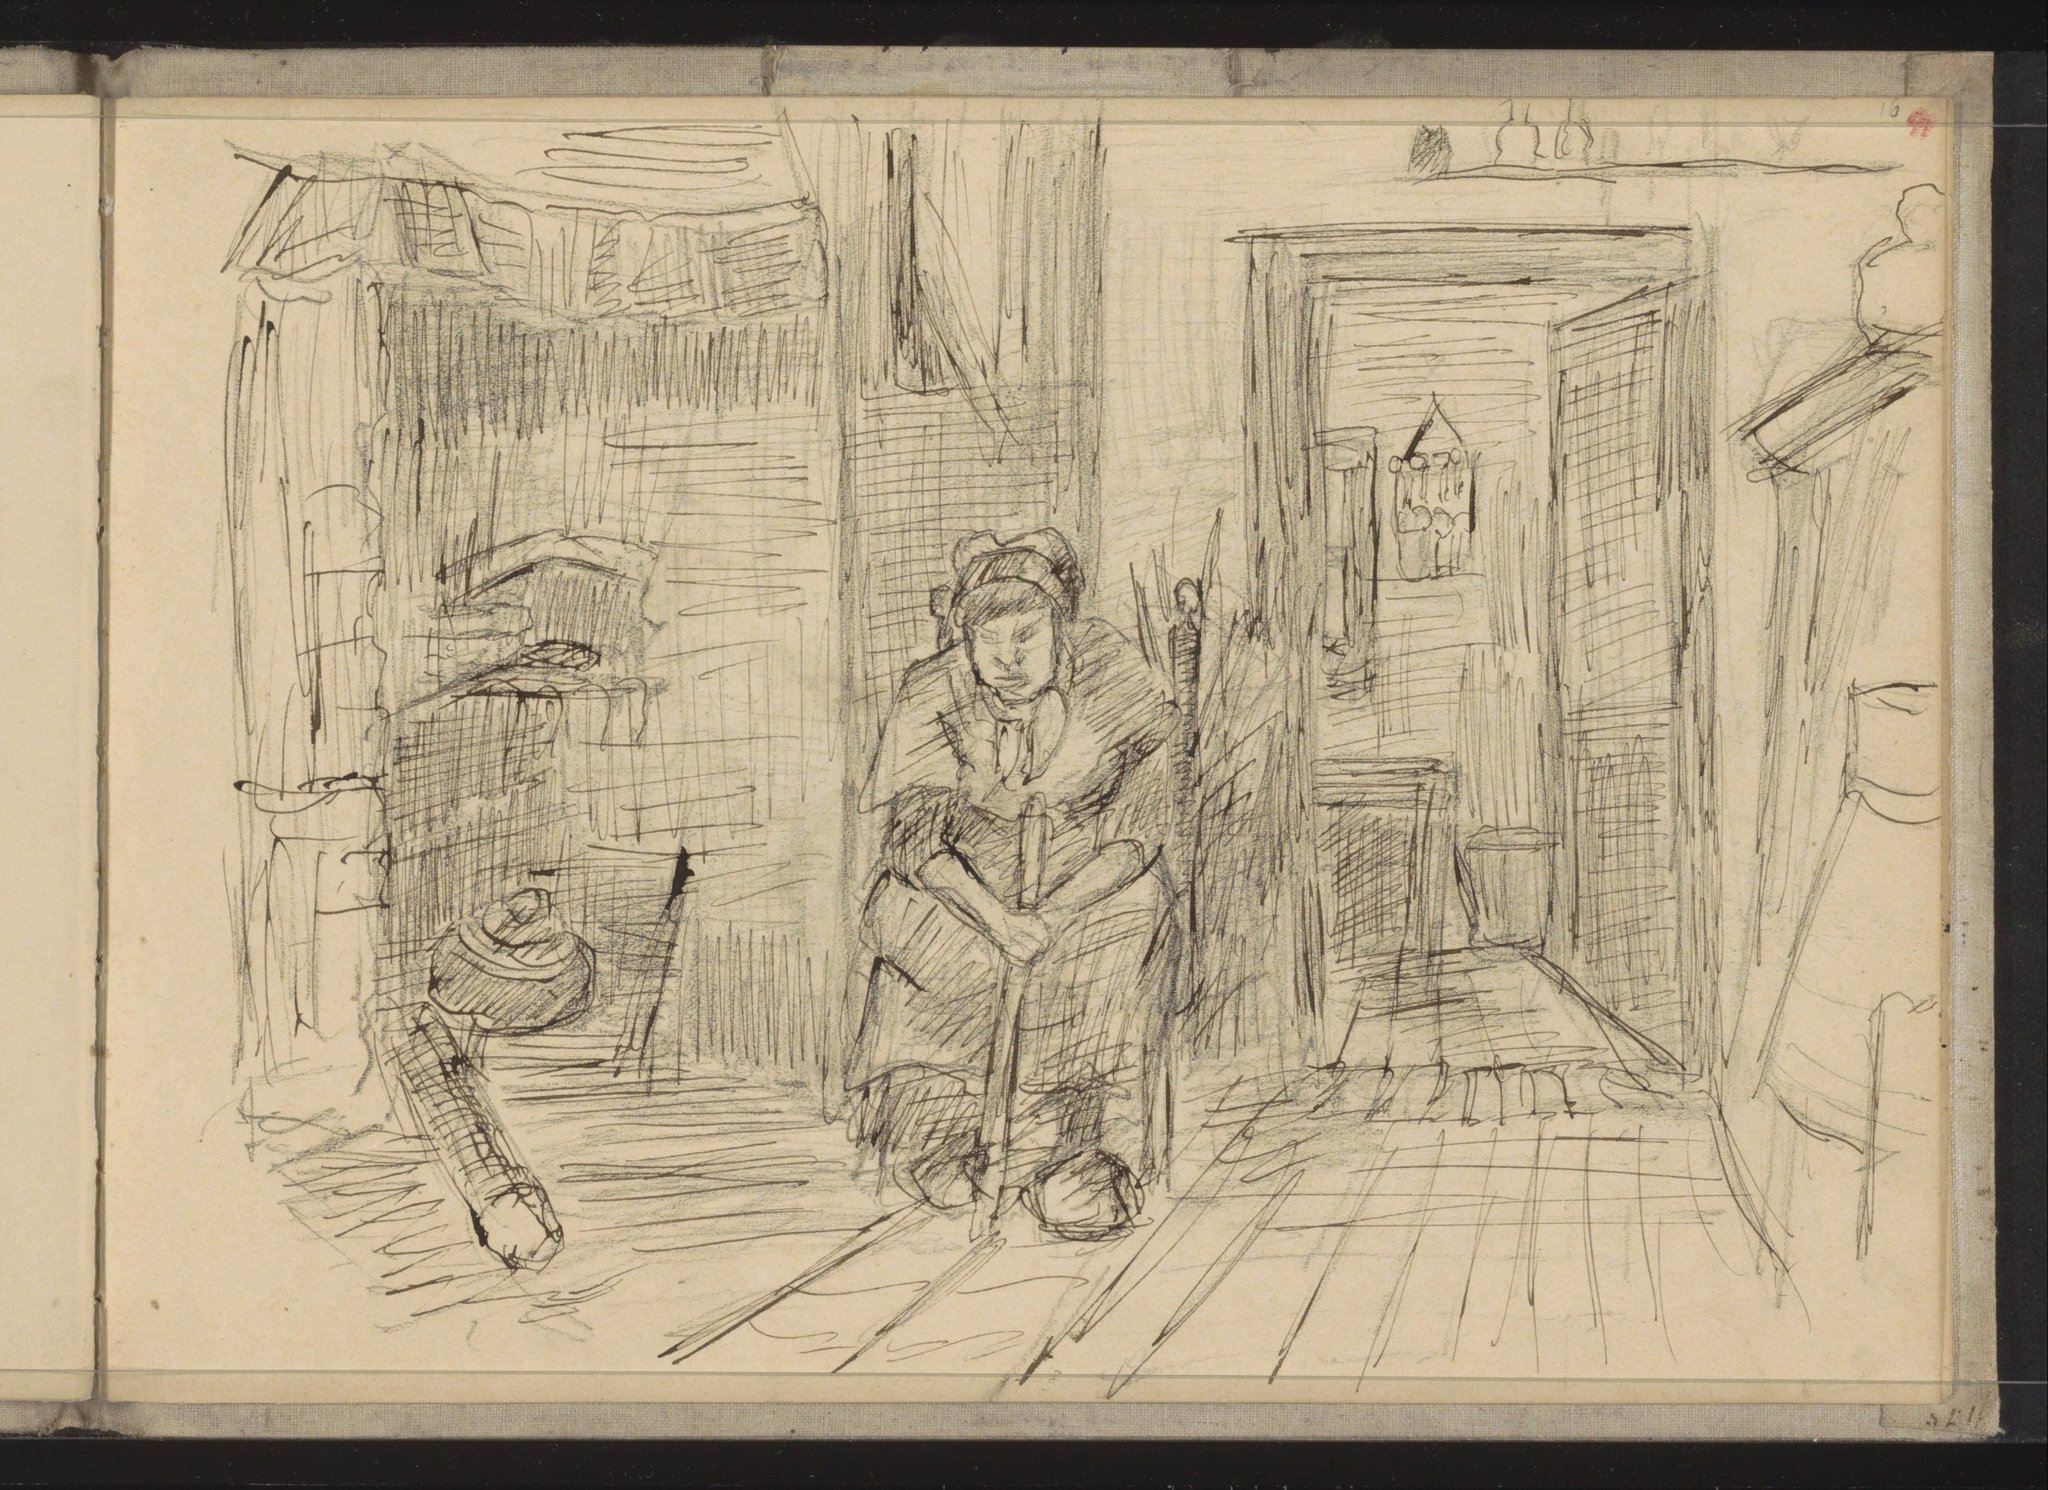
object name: sketchbook leaf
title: Zittende vrouw in een boereninterieur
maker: jozef israëls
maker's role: draughtsman, painter, print maker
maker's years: 1824-1911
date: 1834-1911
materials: ink, paper, pencil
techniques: pen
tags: sitting figure - aa - female human figure, cottage - aa - civic architecture: inside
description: De vrouw zit op een stoel, heeft een stok in haar handen en leunt voorover. Naast haar een doorkijk naar een andere kamer in het huis. Blad 16 recto uit een schetsboek met 18 bladen.